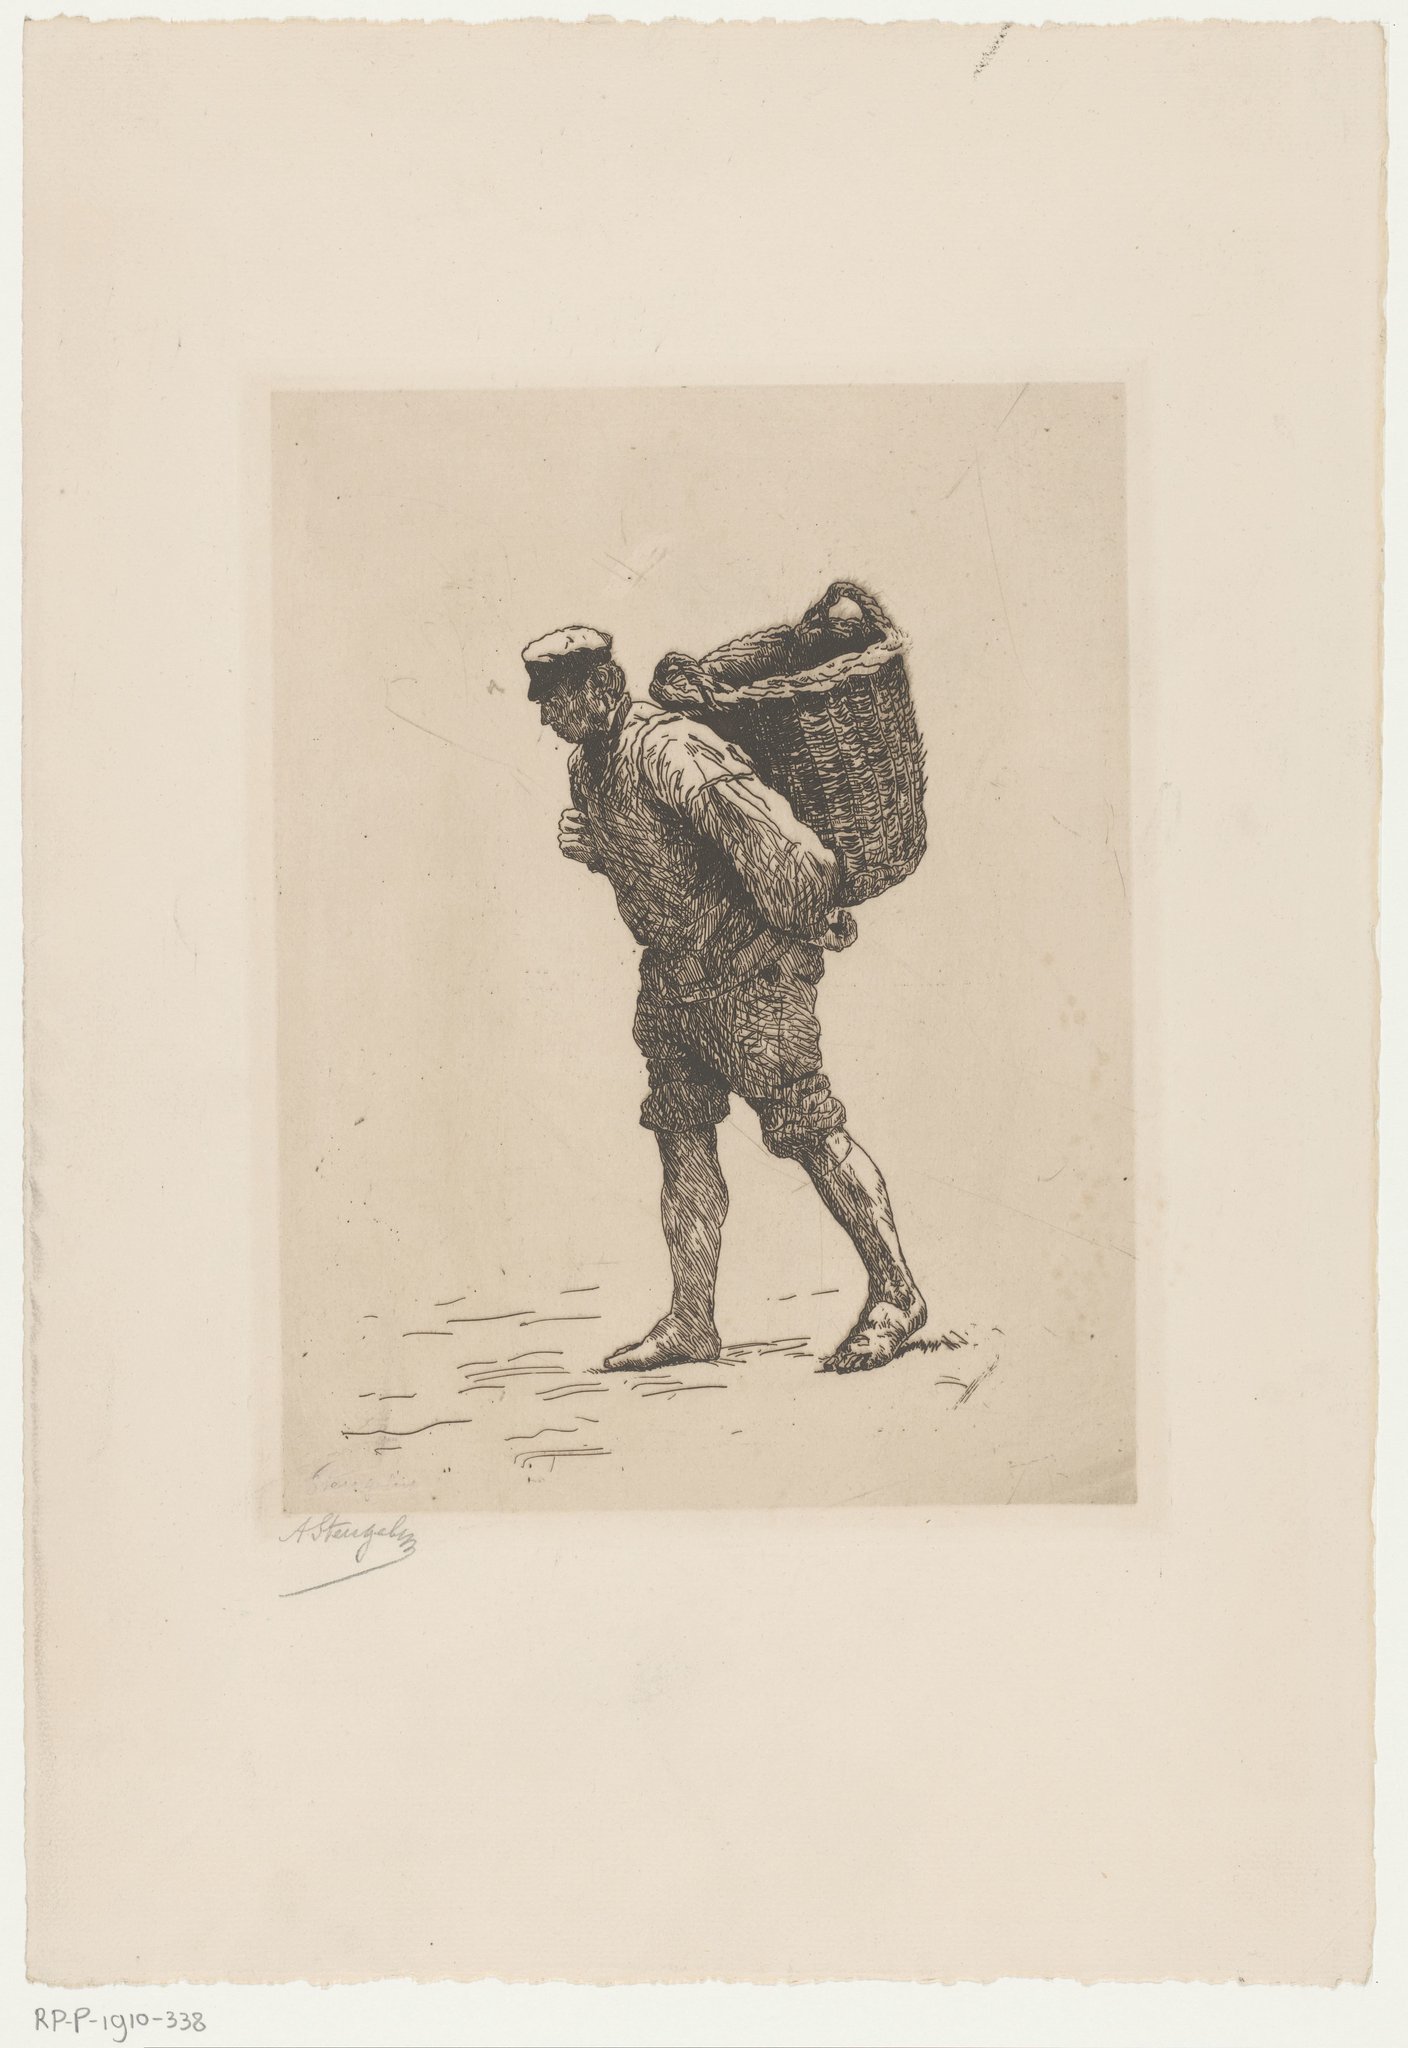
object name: print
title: Porteur de poissons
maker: alphonse stengelin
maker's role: painter, print maker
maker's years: 1852-1938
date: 1862-1910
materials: paper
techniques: etching, intaglio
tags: commercial fishery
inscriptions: collector's mark: Lugt 2233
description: Katwijkse visser, blootsvoets, draagt een mand op zijn rug.